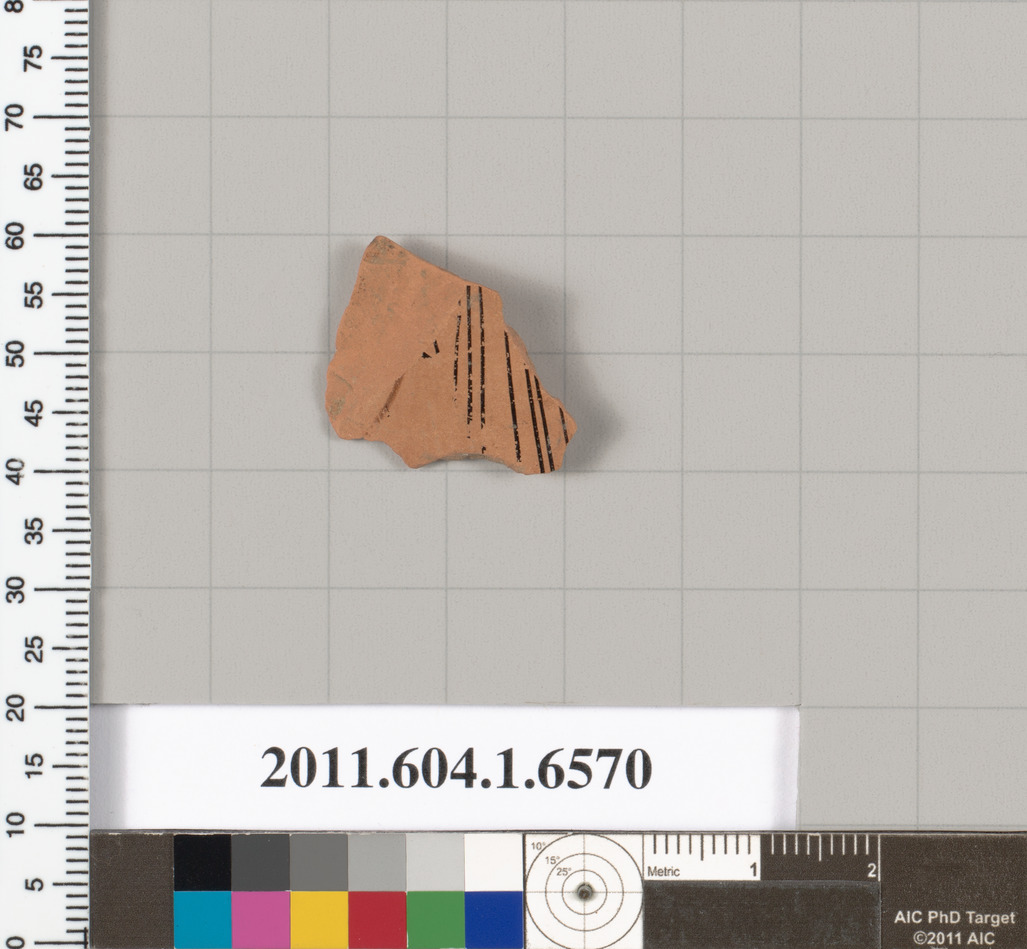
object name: kylix fragment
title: Terracotta fragment of a kylix (drinking cup)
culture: greek, attic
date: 490-480 BCE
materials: terracotta